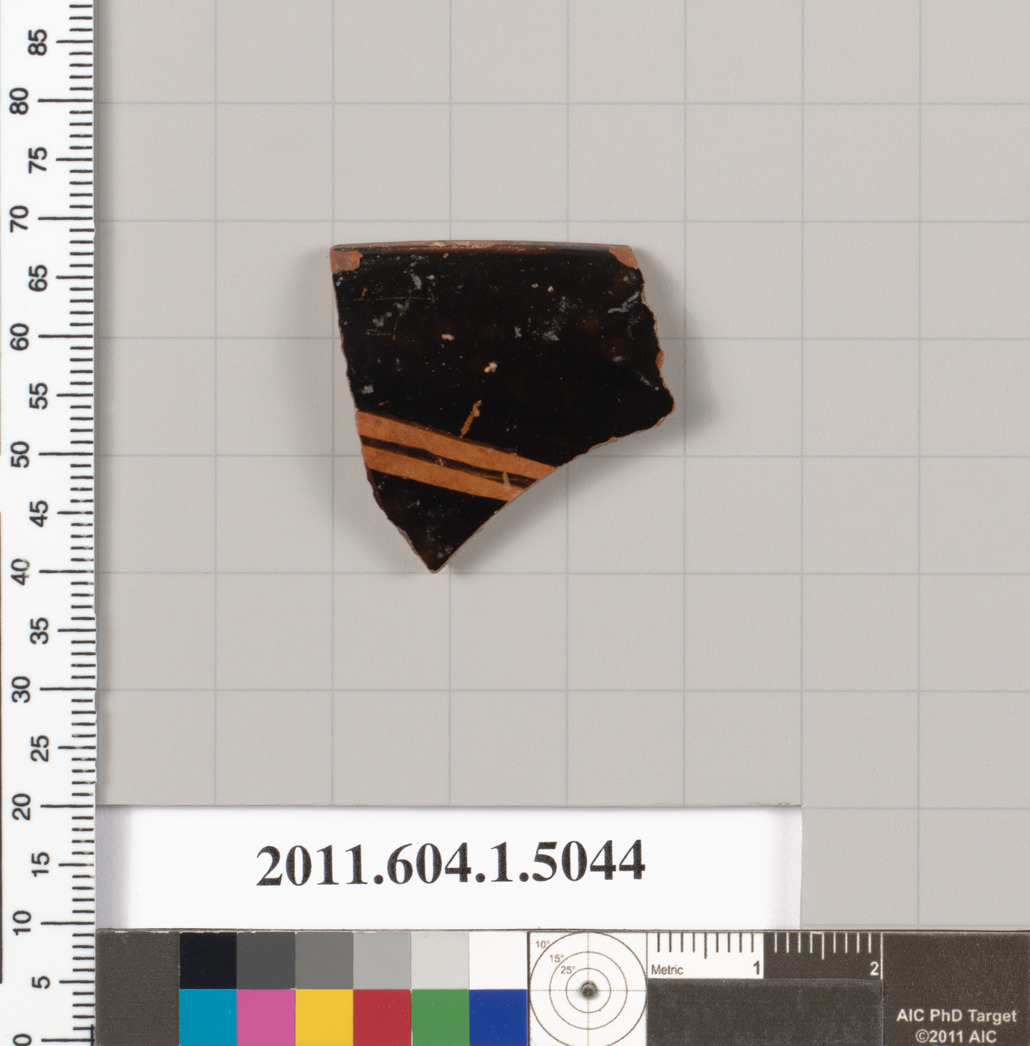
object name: kylix fragment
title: Terracotta fragment of a kylix (drinking cup)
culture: greek, attic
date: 475-451 BCE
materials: terracotta